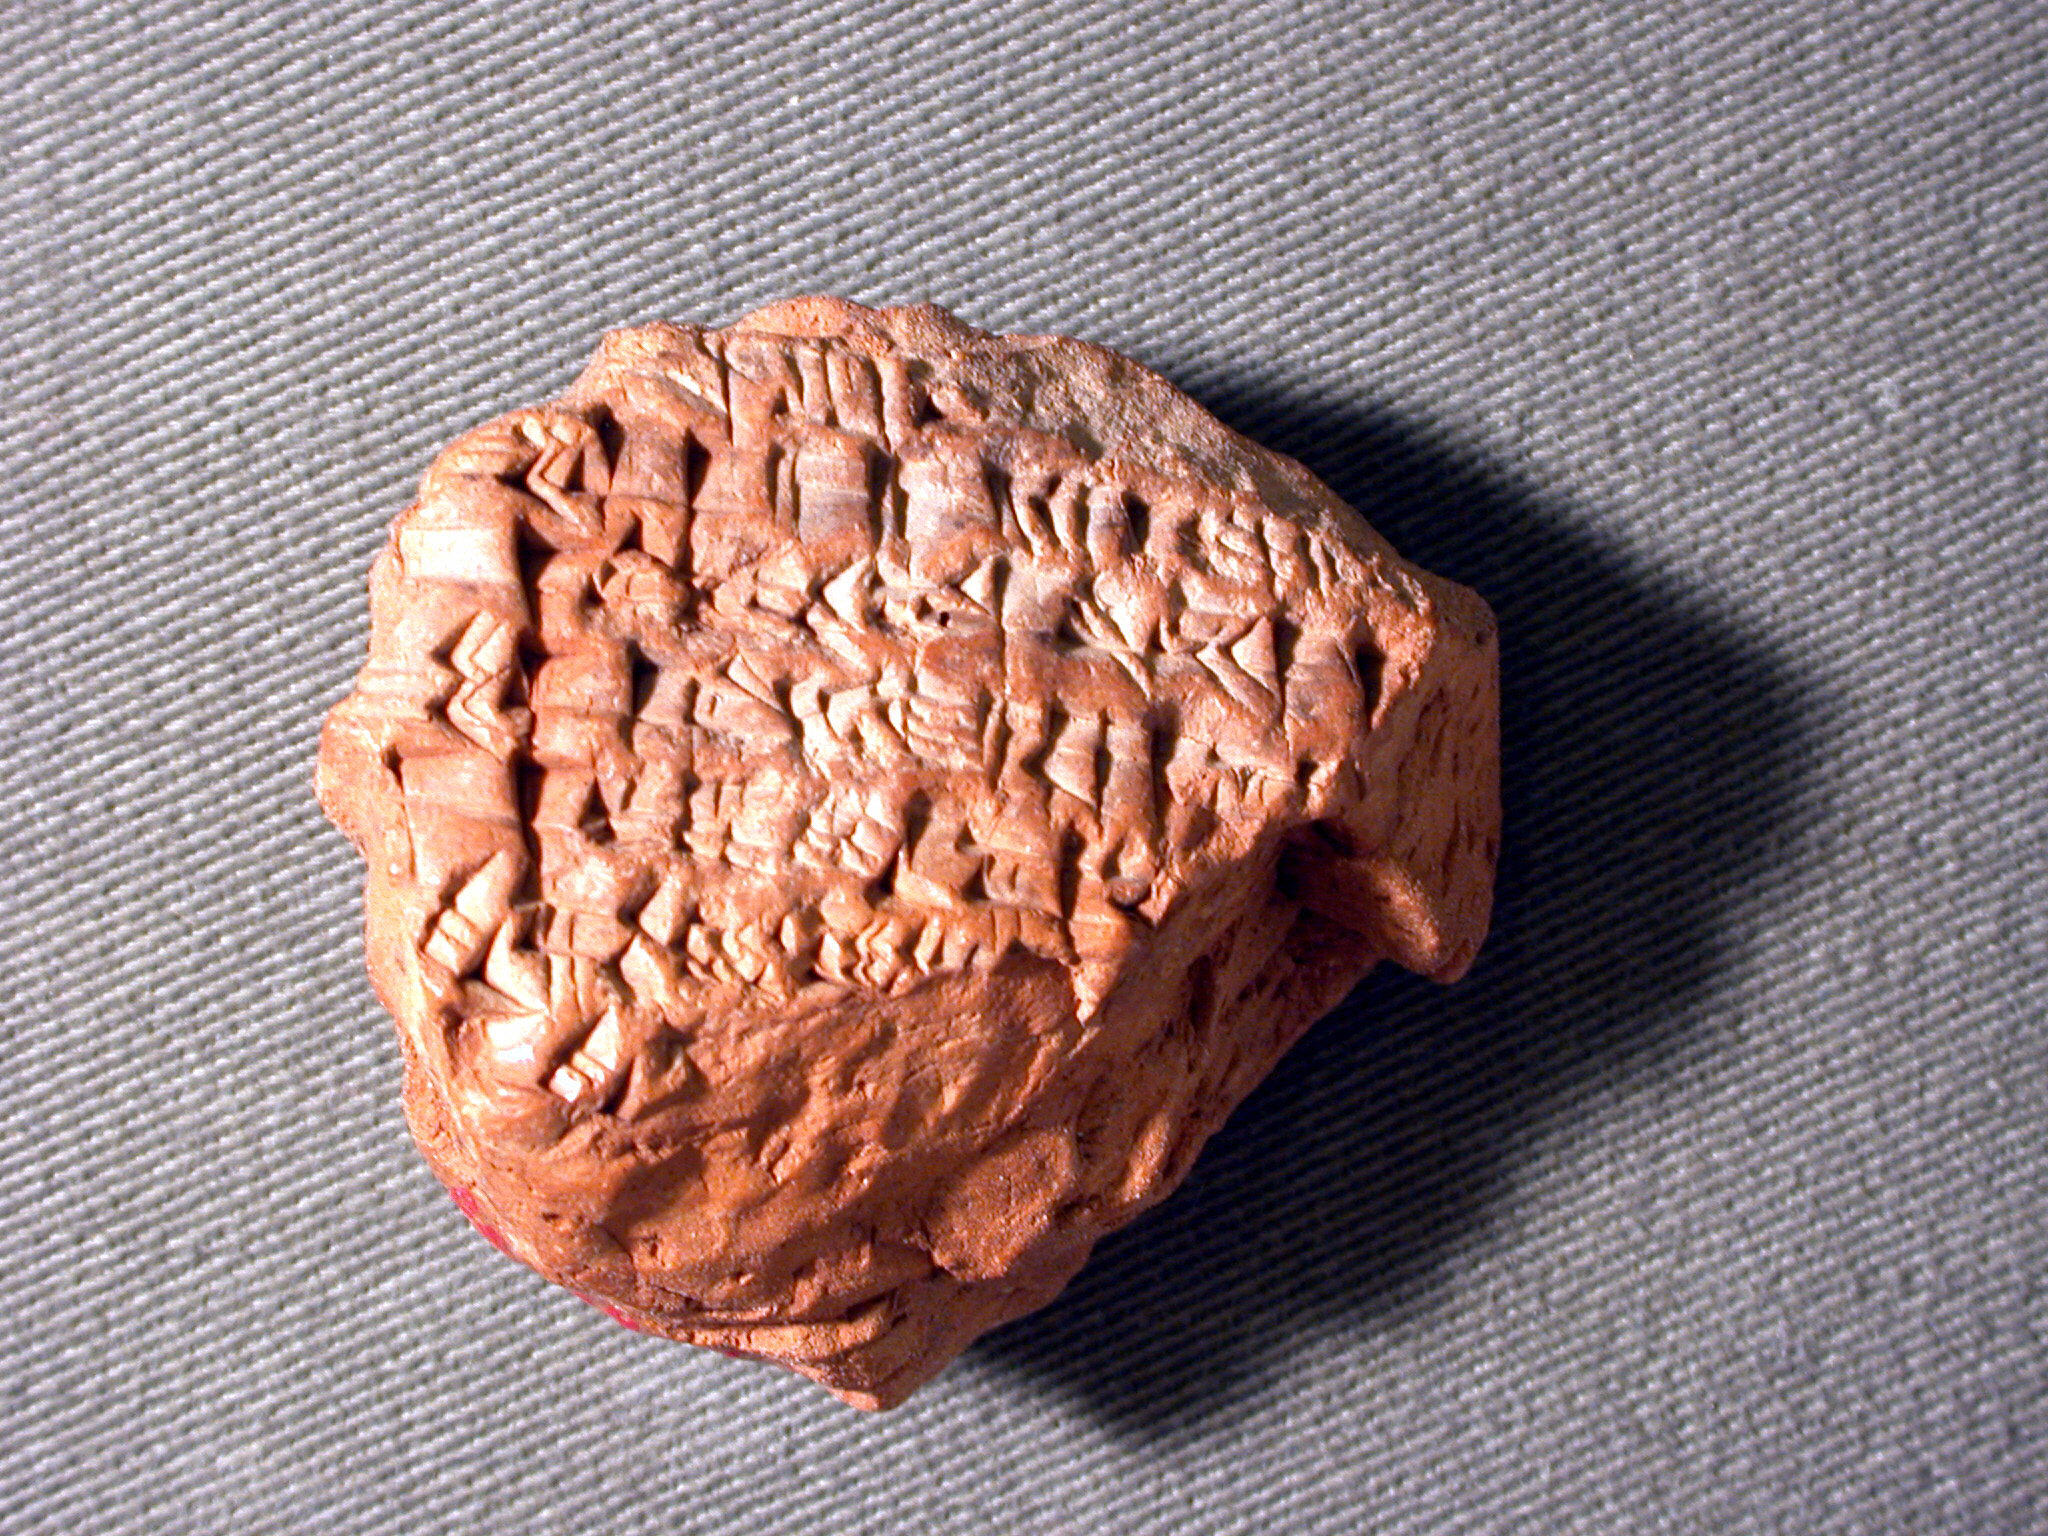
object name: cuneiform tablet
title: Cuneiform tablet: account of barley disbursement, Ebabbar archive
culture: babylonian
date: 700-501 BCE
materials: clay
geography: mesopotamia